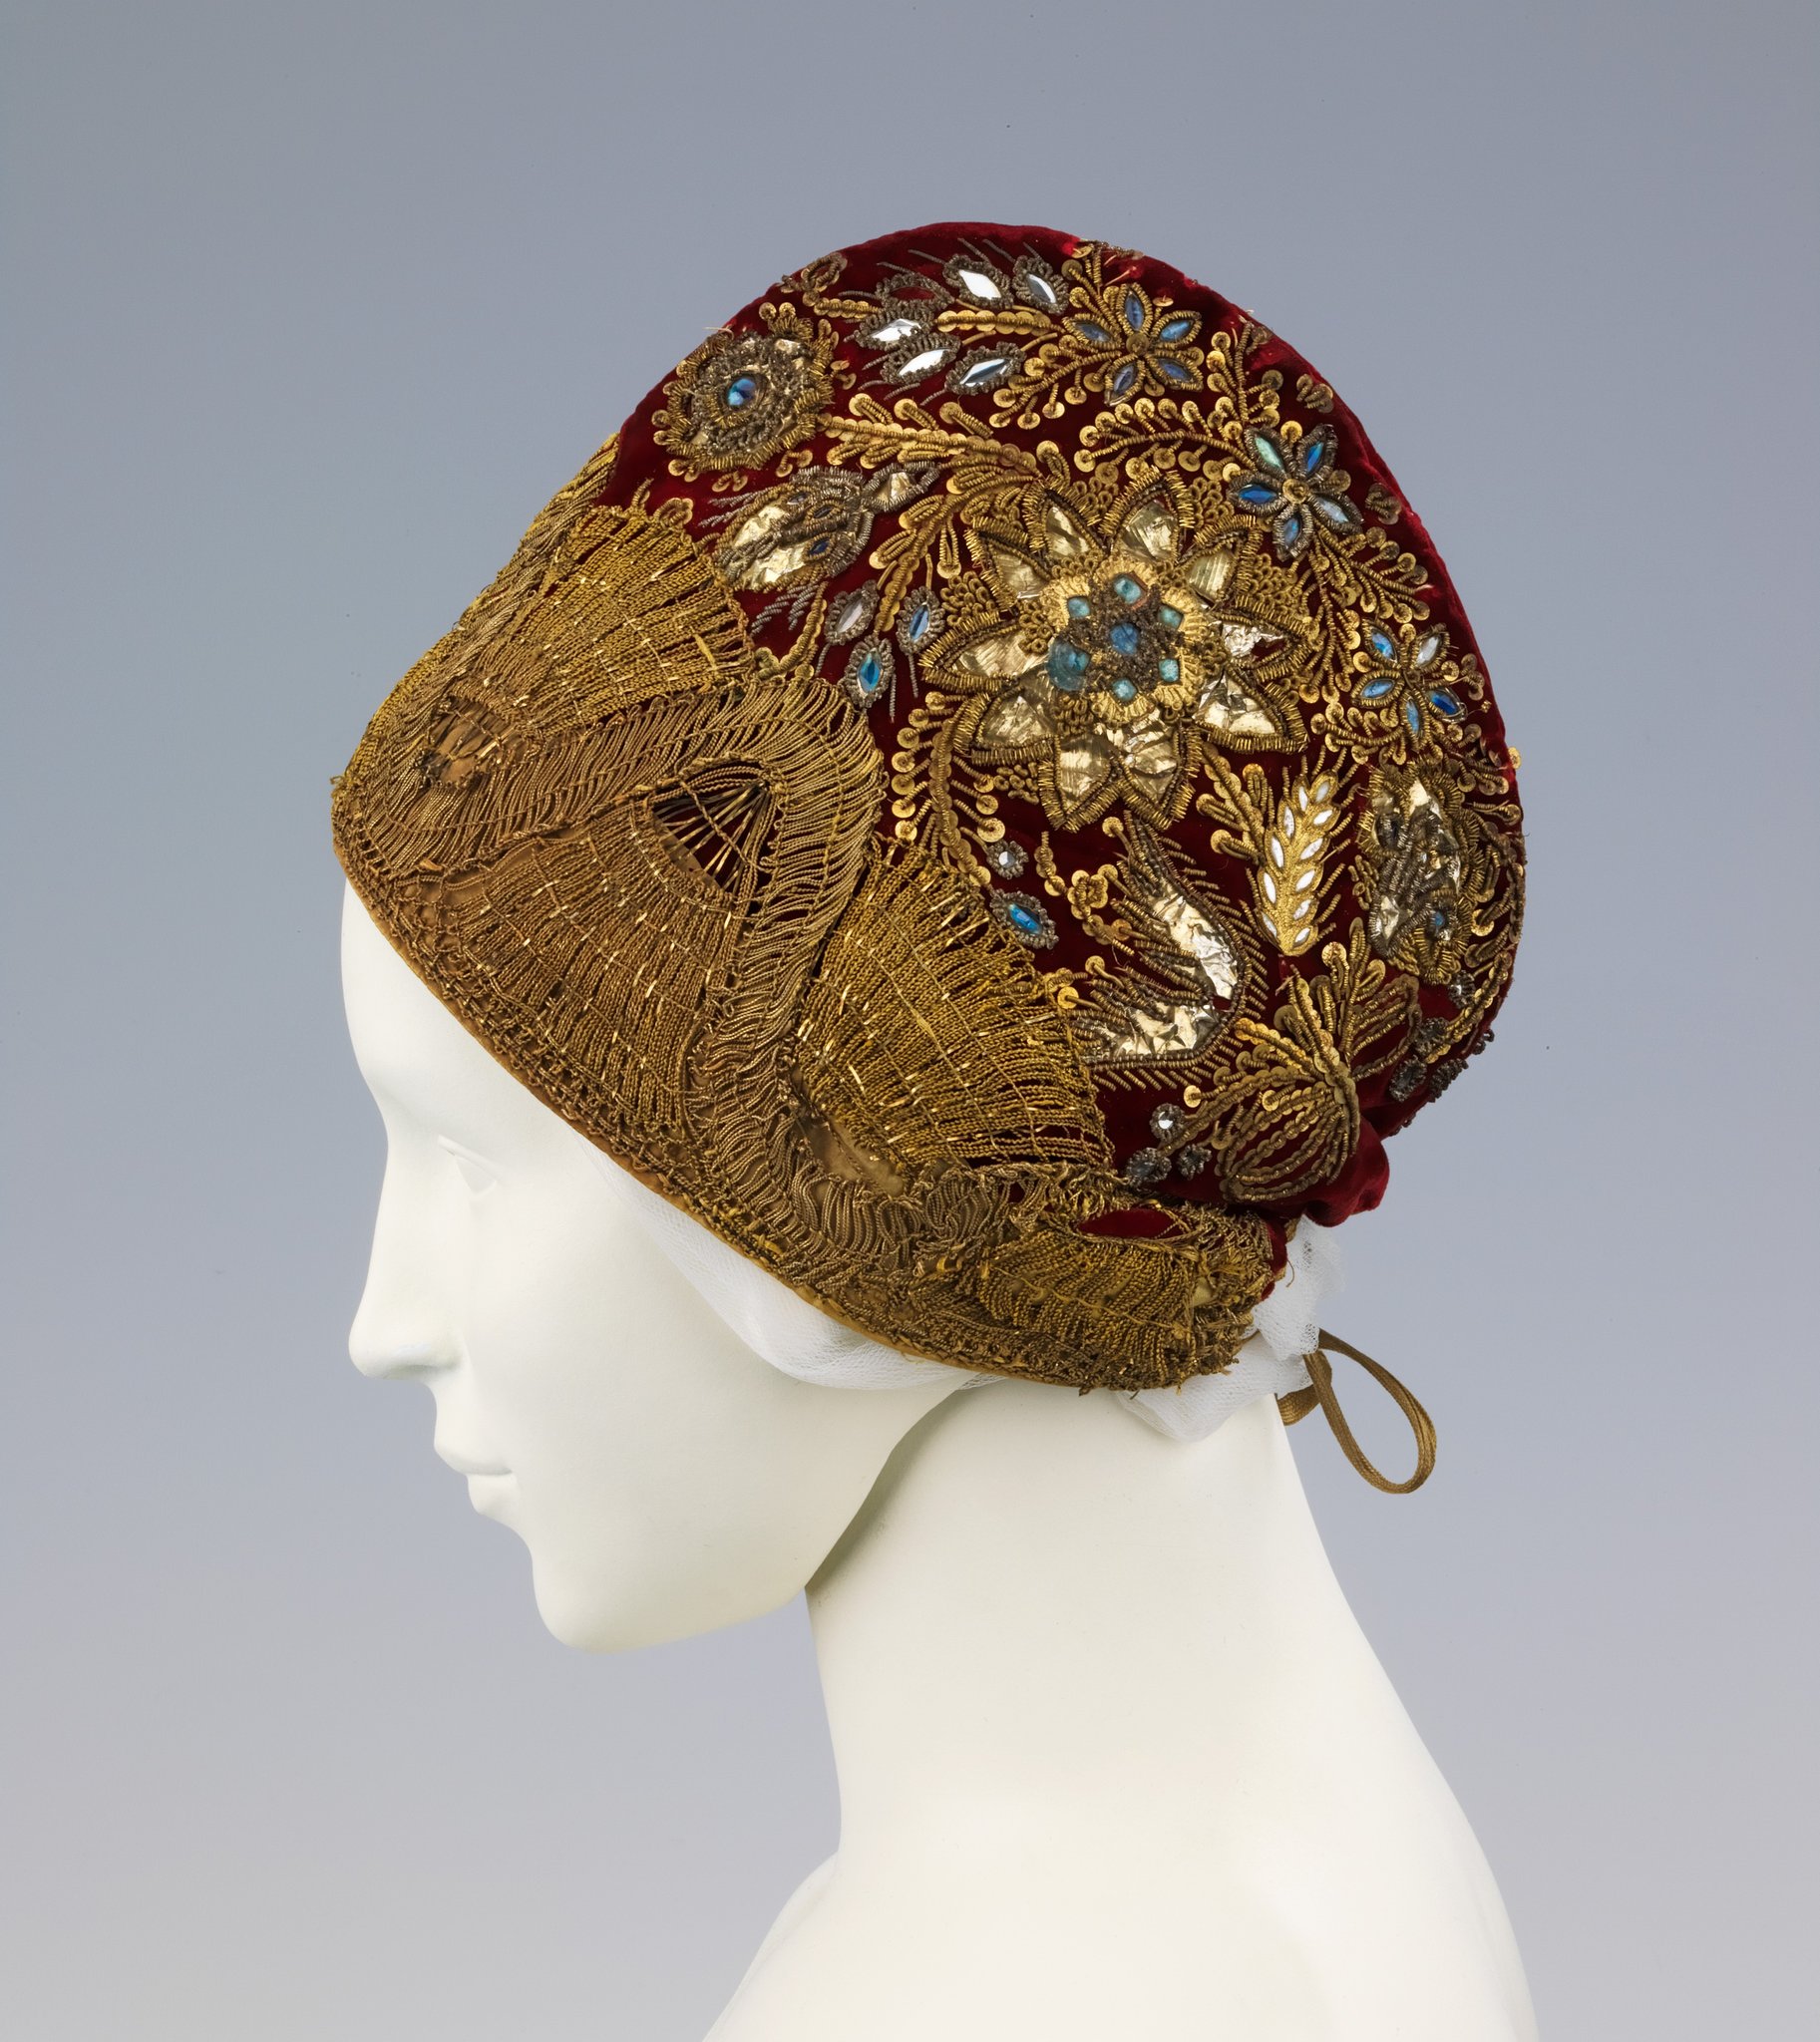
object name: cap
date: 1876-1900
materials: cotton, glass, metal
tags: flowers